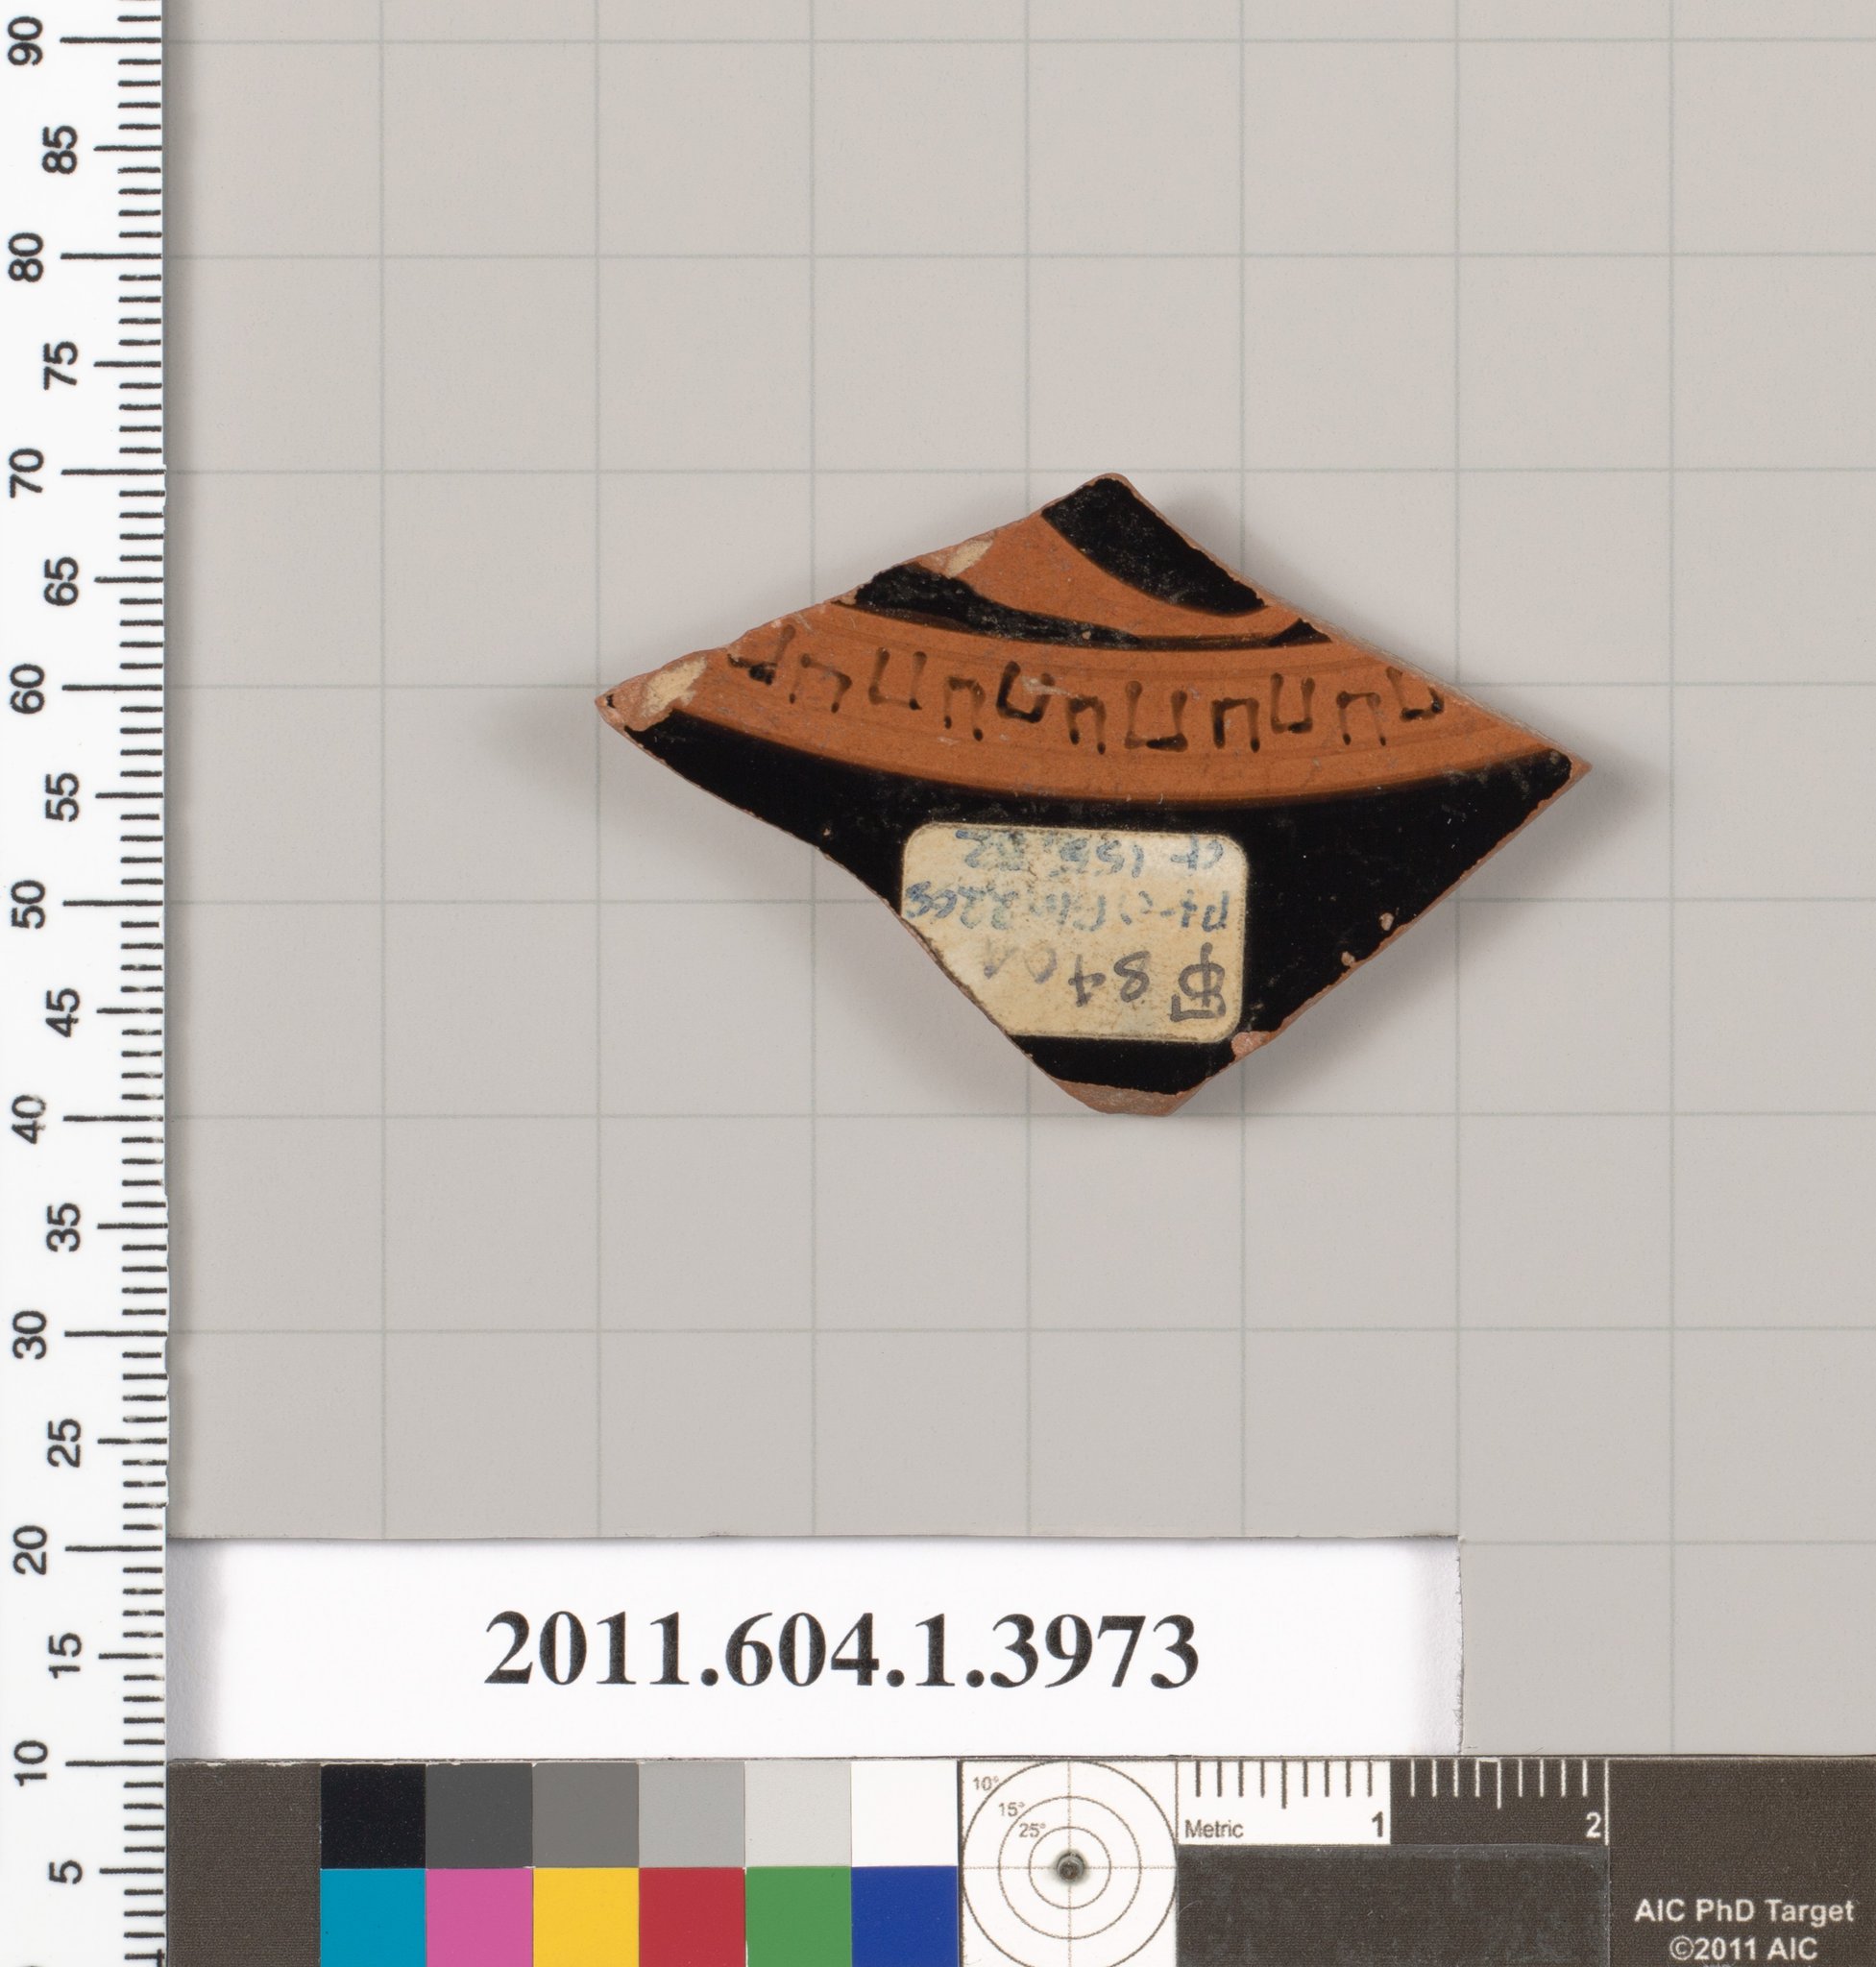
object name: kylix fragment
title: Terracotta fragment of a kylix (drinking cup)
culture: greek, attic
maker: painter of berlin 2268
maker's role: artist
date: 510-500 BCE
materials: terracotta